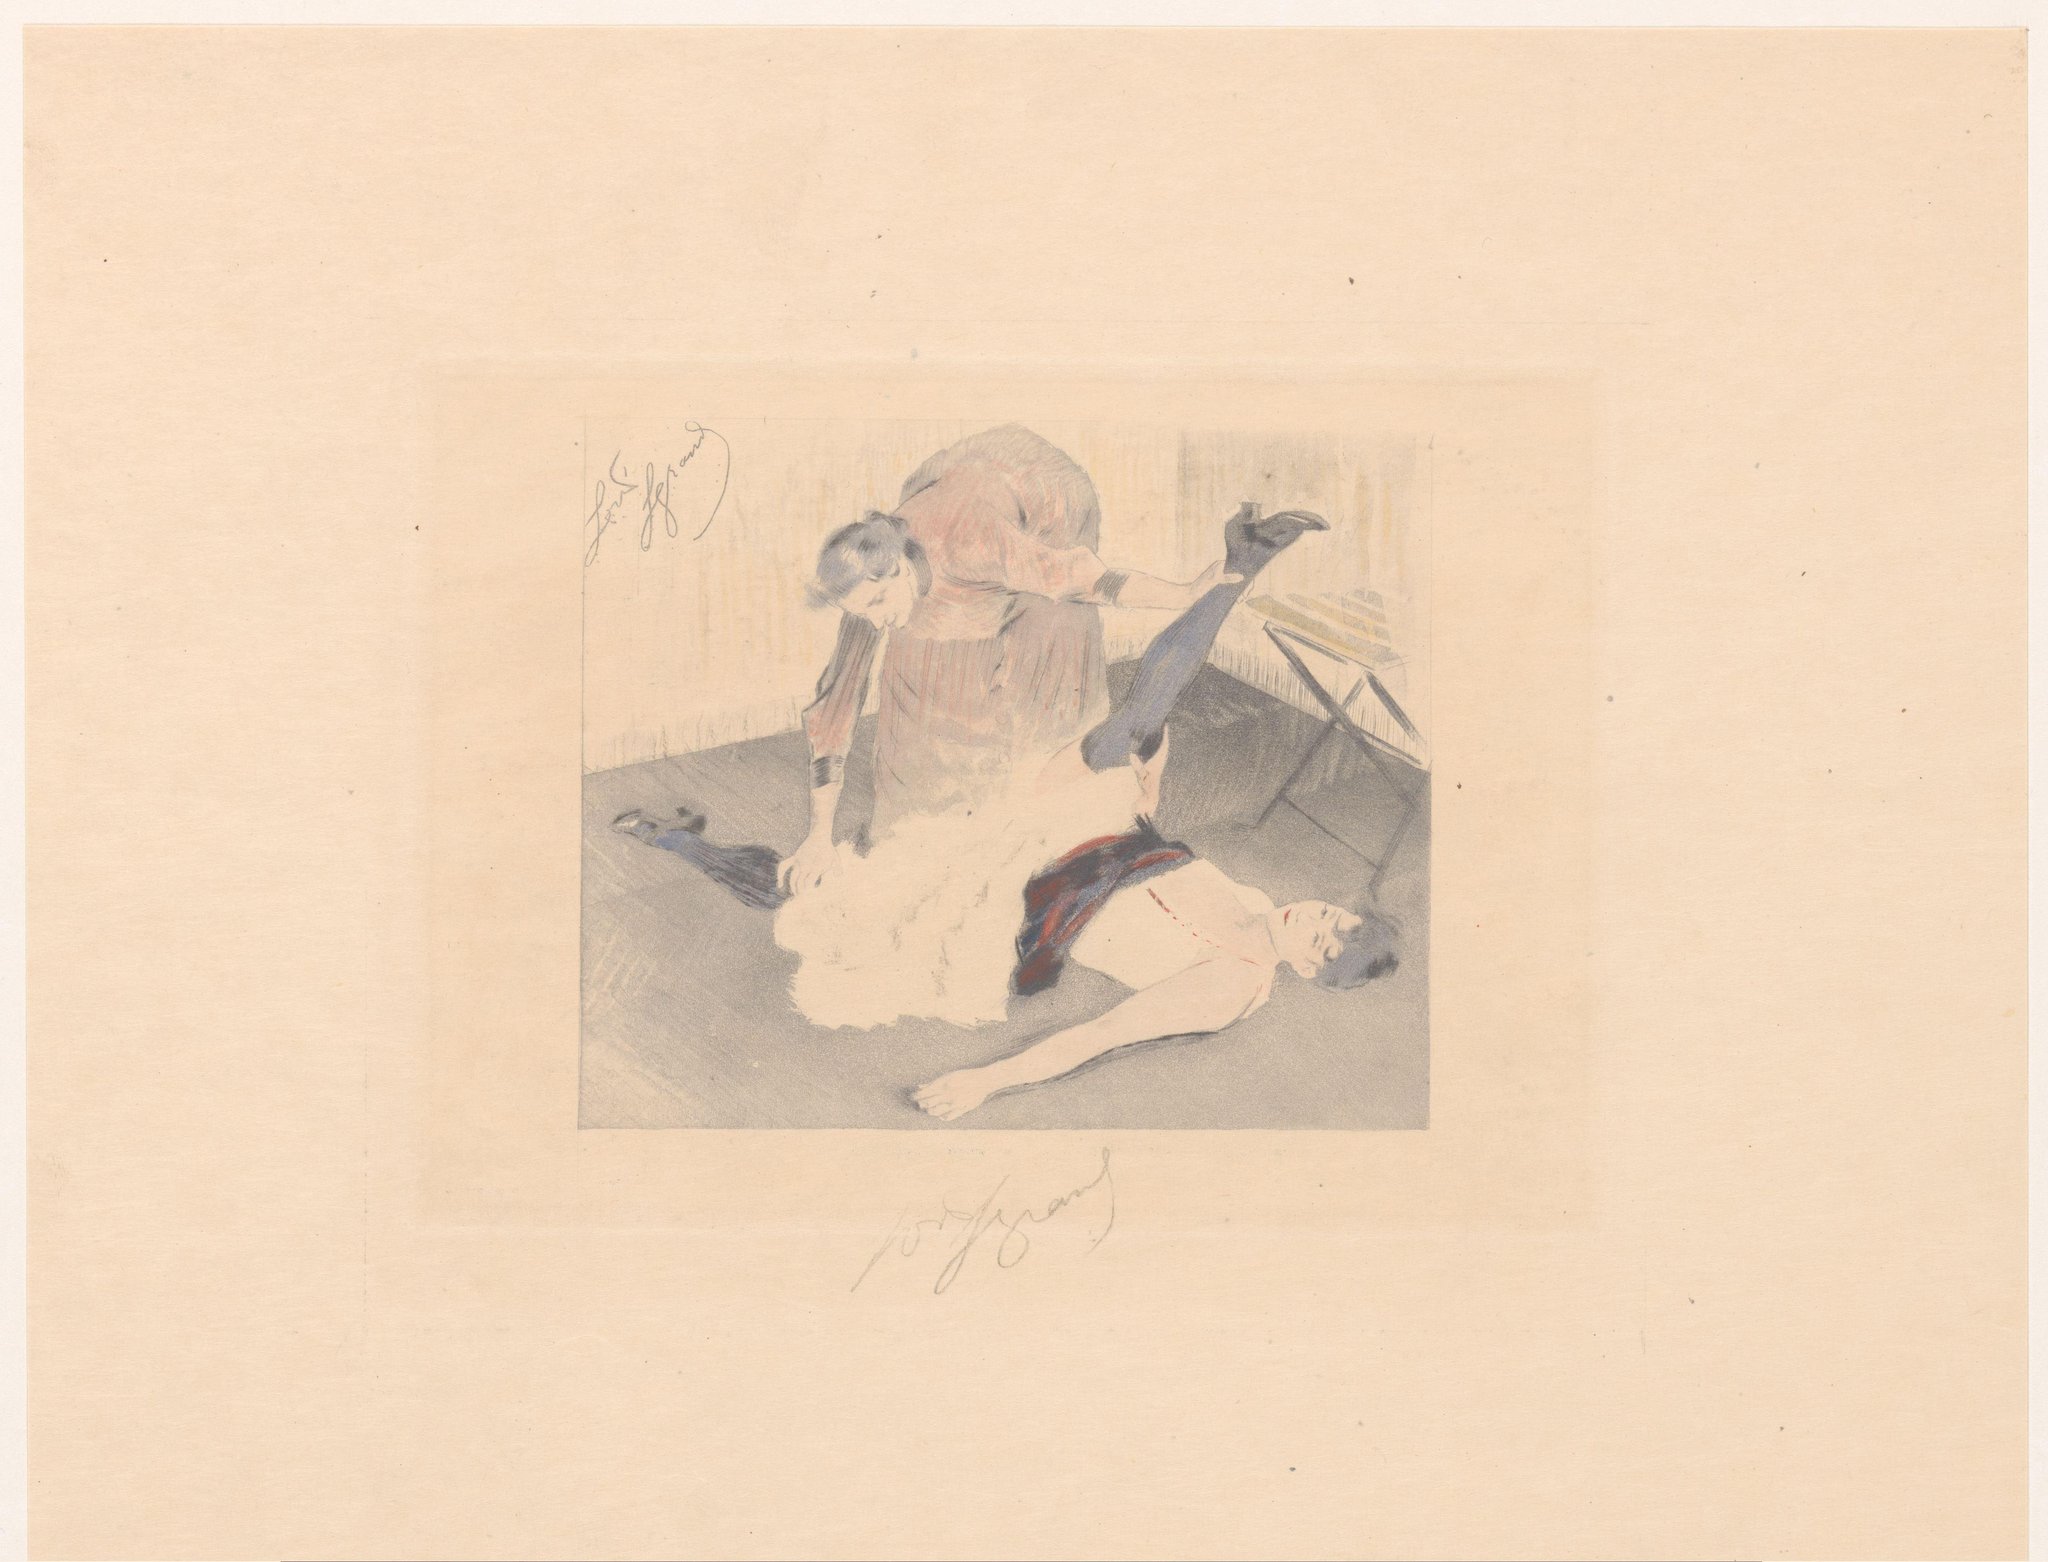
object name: print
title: Brisement à terre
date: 1892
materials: paper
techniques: drypoint, engraving, etching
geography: france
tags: teacher and pupil, female dancer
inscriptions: collector's mark: Lugt 2228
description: Prent uit: Legrand, Louis. Cours de danse fin de siècle. Parijs: Edouard Dentu, 1892.